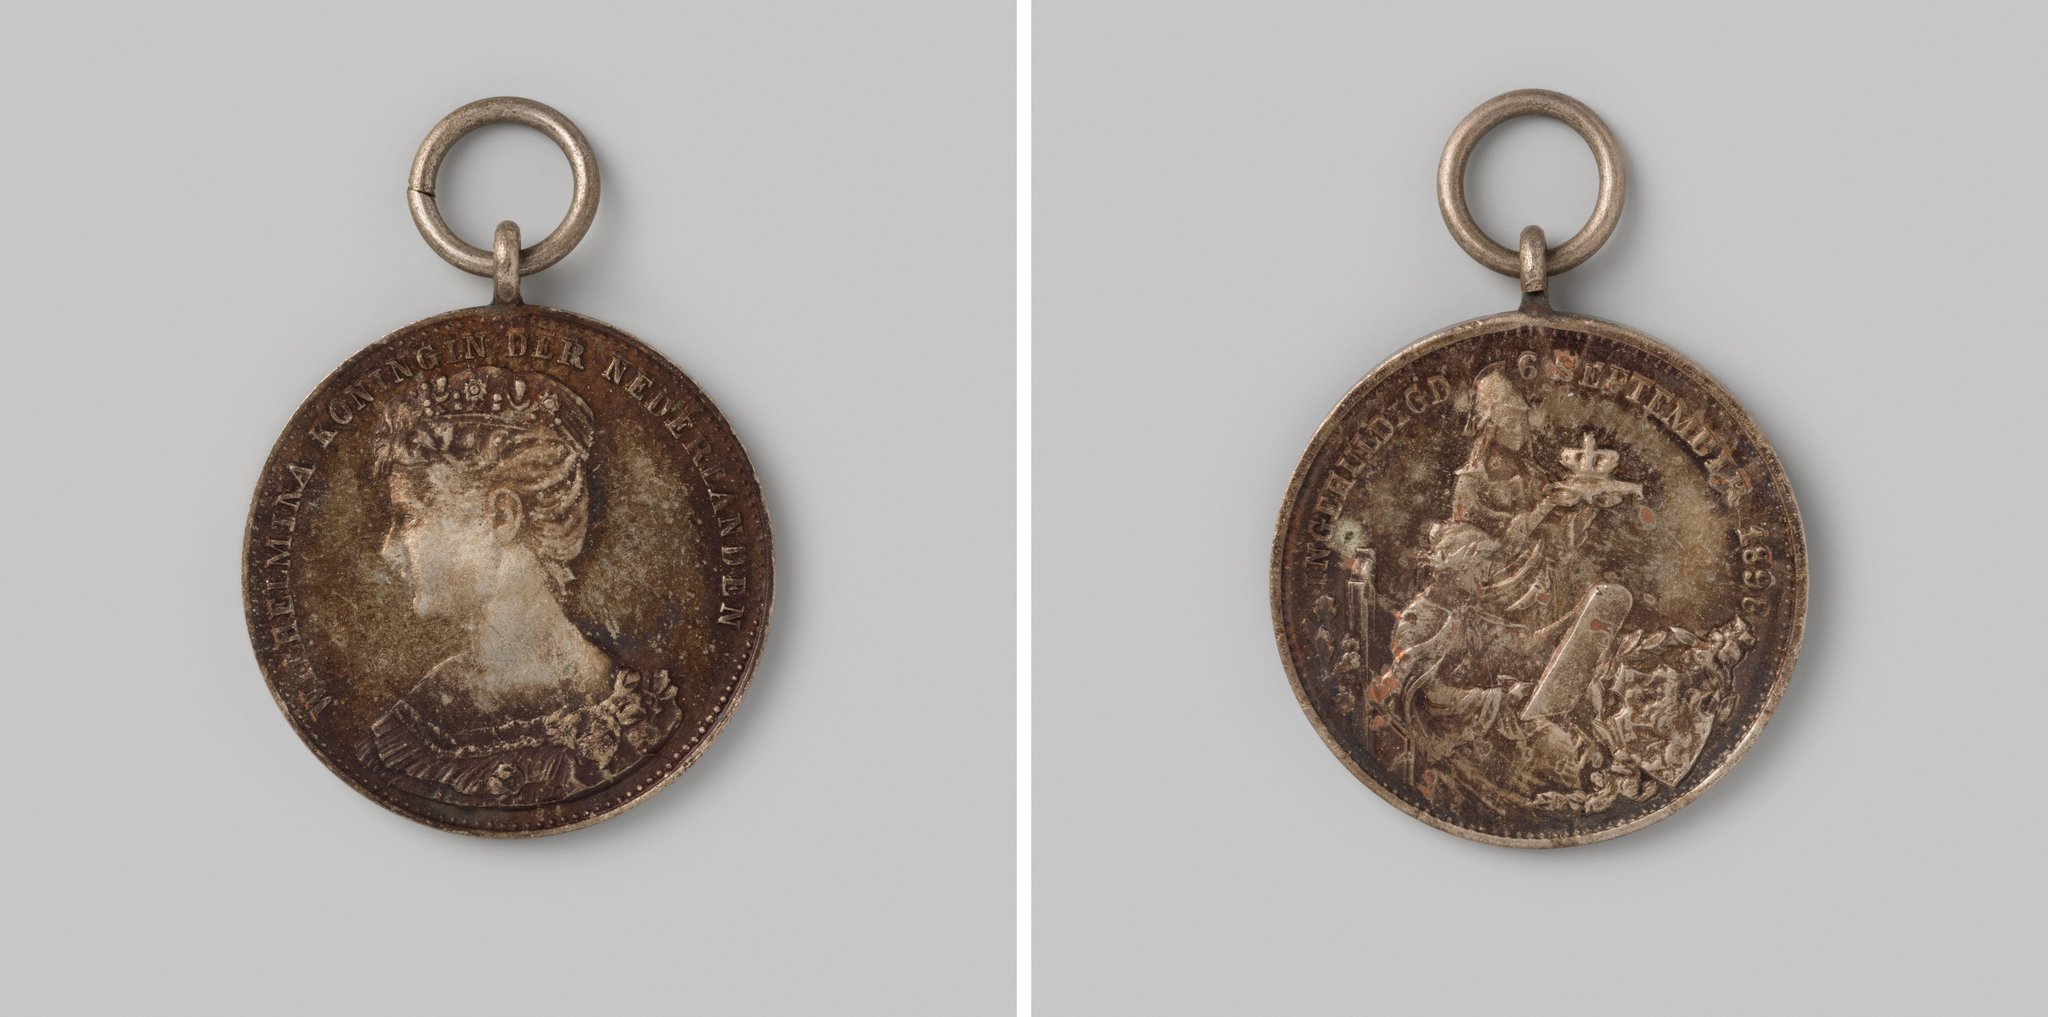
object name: history medal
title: Inhuldiging van Koningin Wilhelmina 1898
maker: j.a.a. gerritsen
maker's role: manufacturer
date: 1898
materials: brass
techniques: striking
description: Verzilverde penning met bal en draagoog, op de voorzijde het borstbeeld van Wilhelmina met omschrift, op de keerzijde de Nederlandse Maagd met de koningskroon op een kussen, voor haar de Geschiedenis als zittende vrouw die de gebeurtenis aantekent, met onderaan eiken- en lauwerloof en het Nederlandse wapenschild, met omschrift.